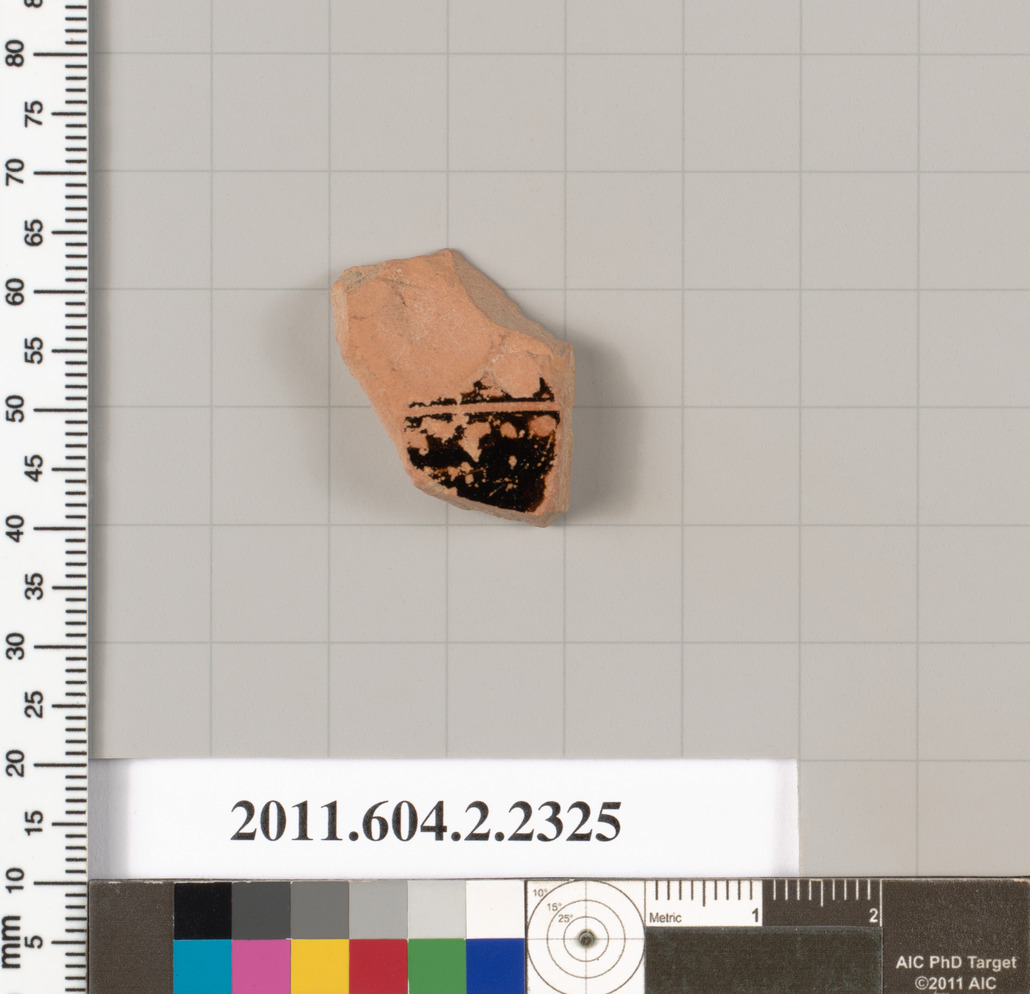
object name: skyphos fragment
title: Terracotta fragment of a skyphos (deep drinking cup)?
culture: greek, attic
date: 475-451 BCE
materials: terracotta